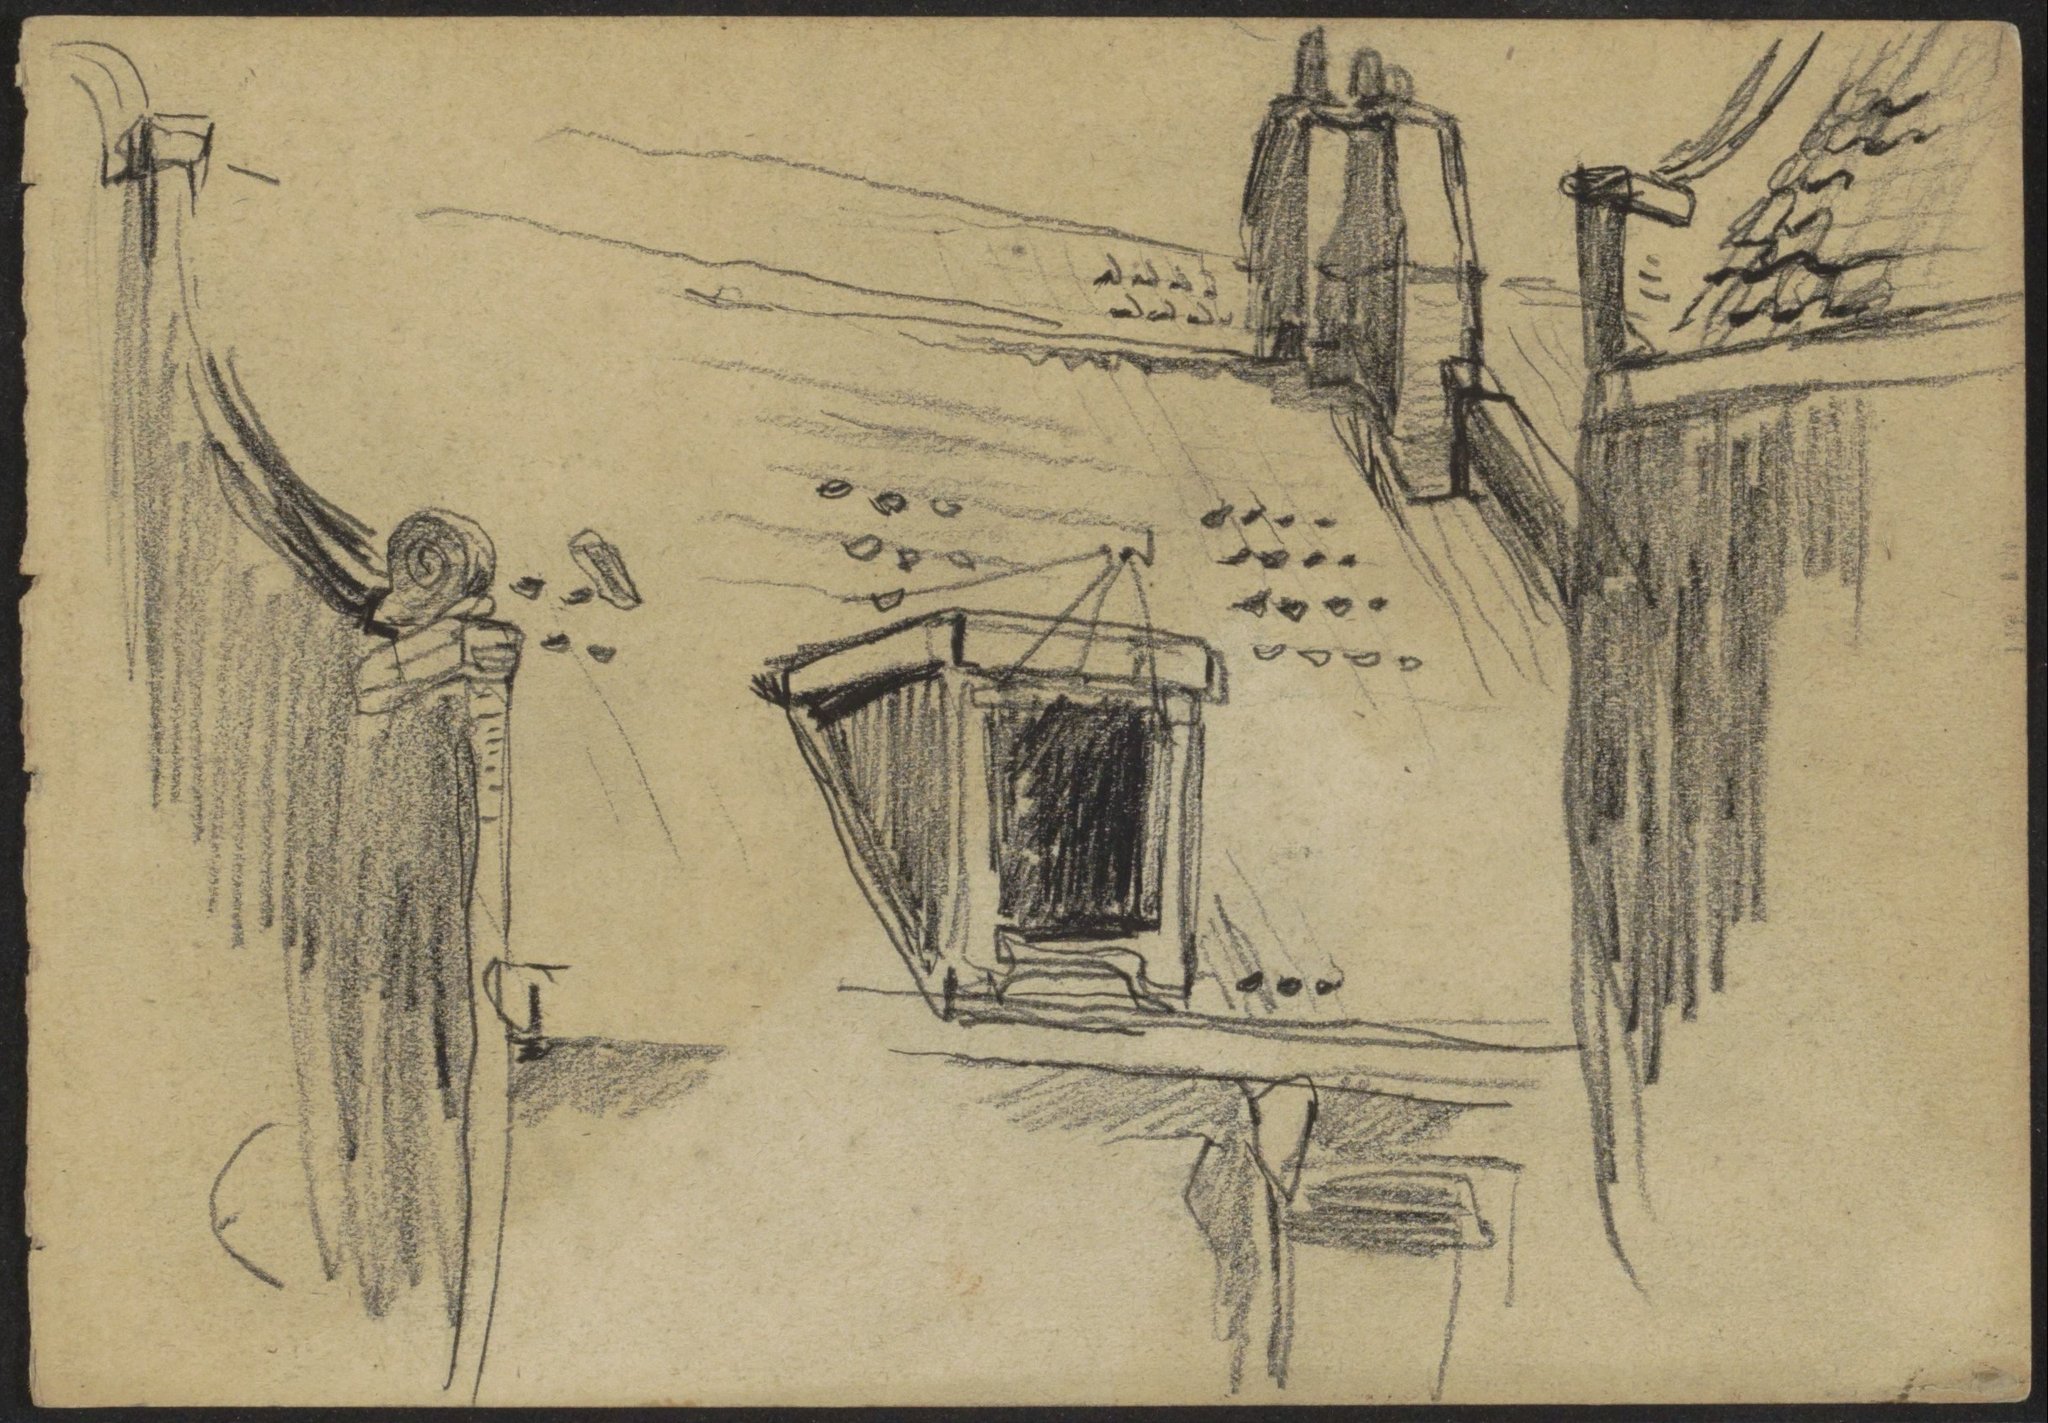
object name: sketchbook leaf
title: Dak van het pand Krom Boomssloot 69 in Amsterdam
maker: willem witsen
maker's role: draughtsman, painter, print maker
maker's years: 1860-1923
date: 1907-1909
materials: paper, pencil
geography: amsterdam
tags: roof (of house or building)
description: Witsen begon met het vervaardigen van de prenten in september 1907.